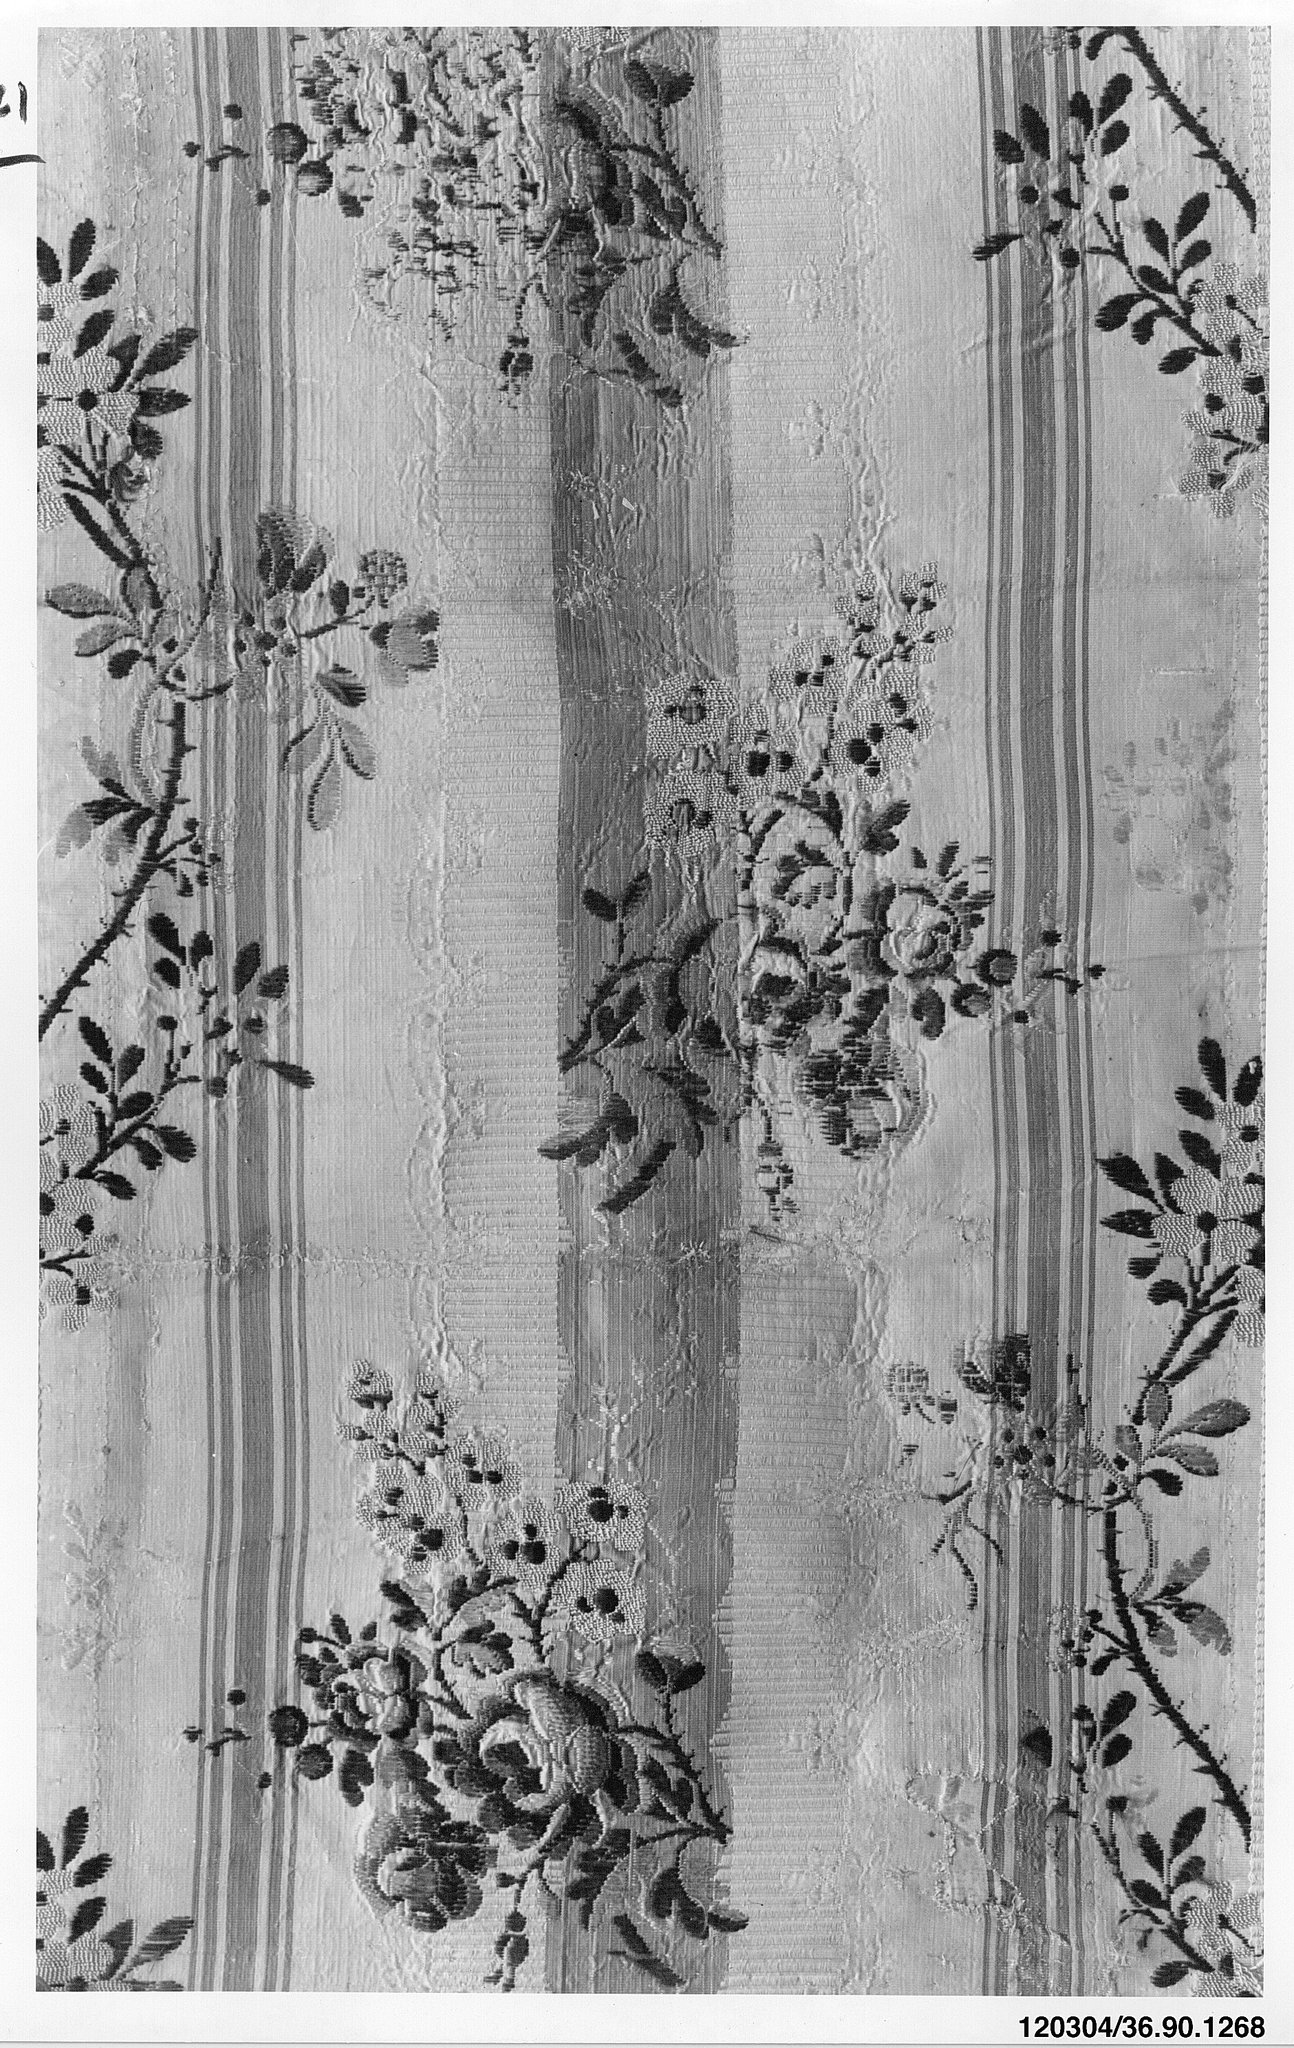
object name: piece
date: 1701-1800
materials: silk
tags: flowers,leaves